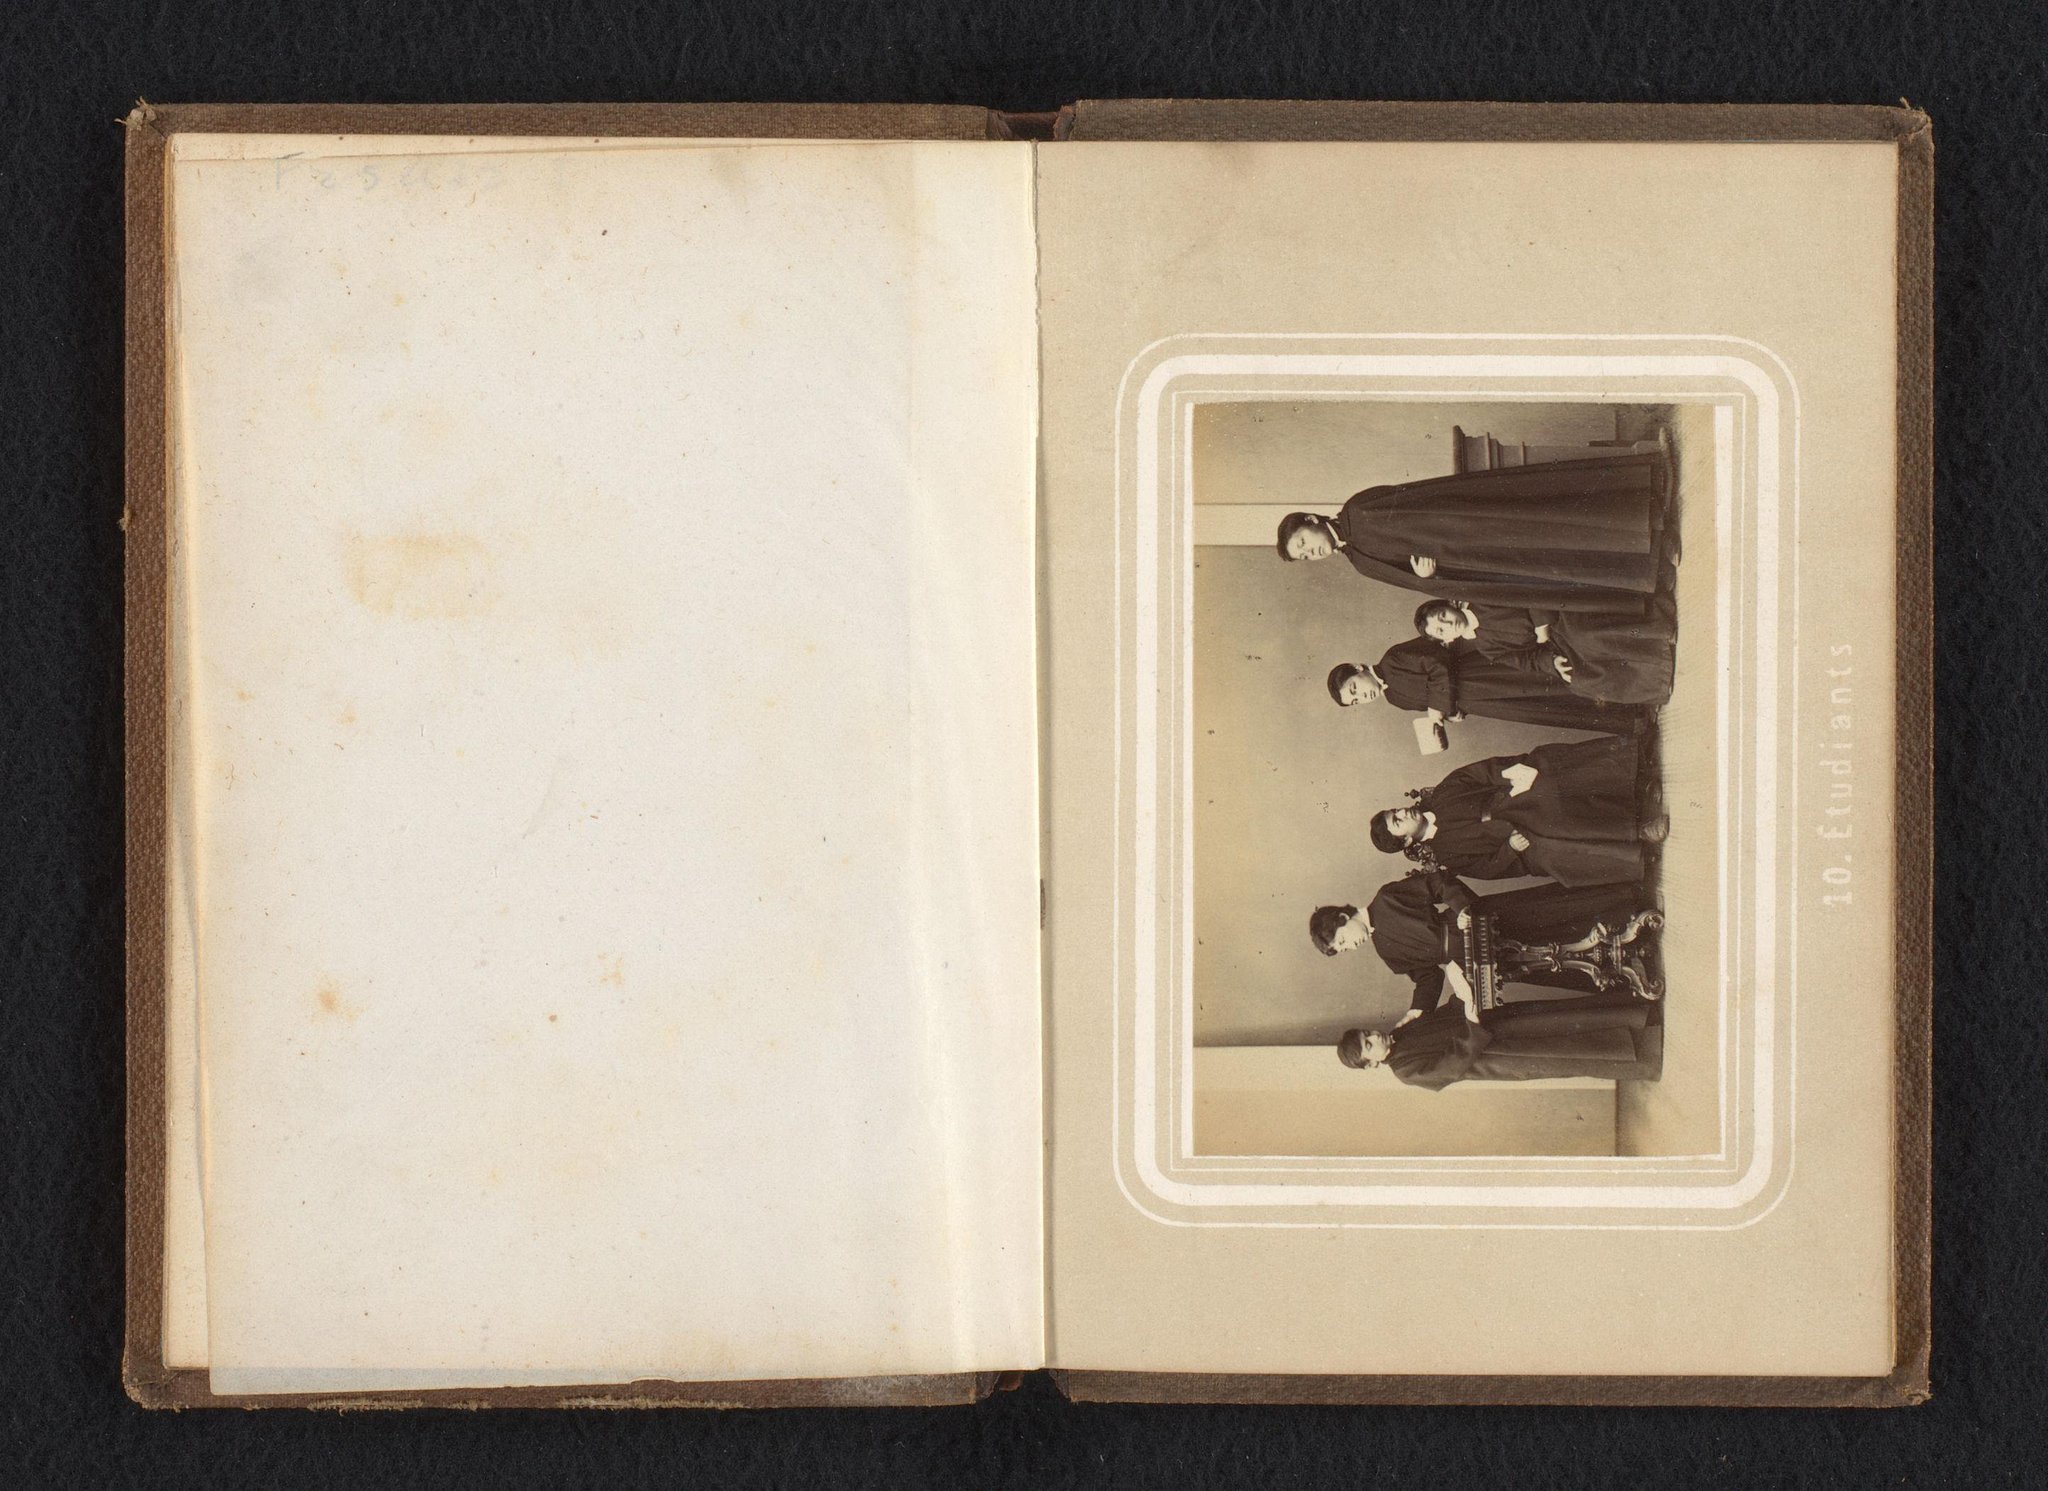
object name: photograph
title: Etudiants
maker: Anonymous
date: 1870-1890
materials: paper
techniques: albumen print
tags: student, anonymous historical persons portrayed in a group, in a group-portrait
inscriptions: number: ‘10.’